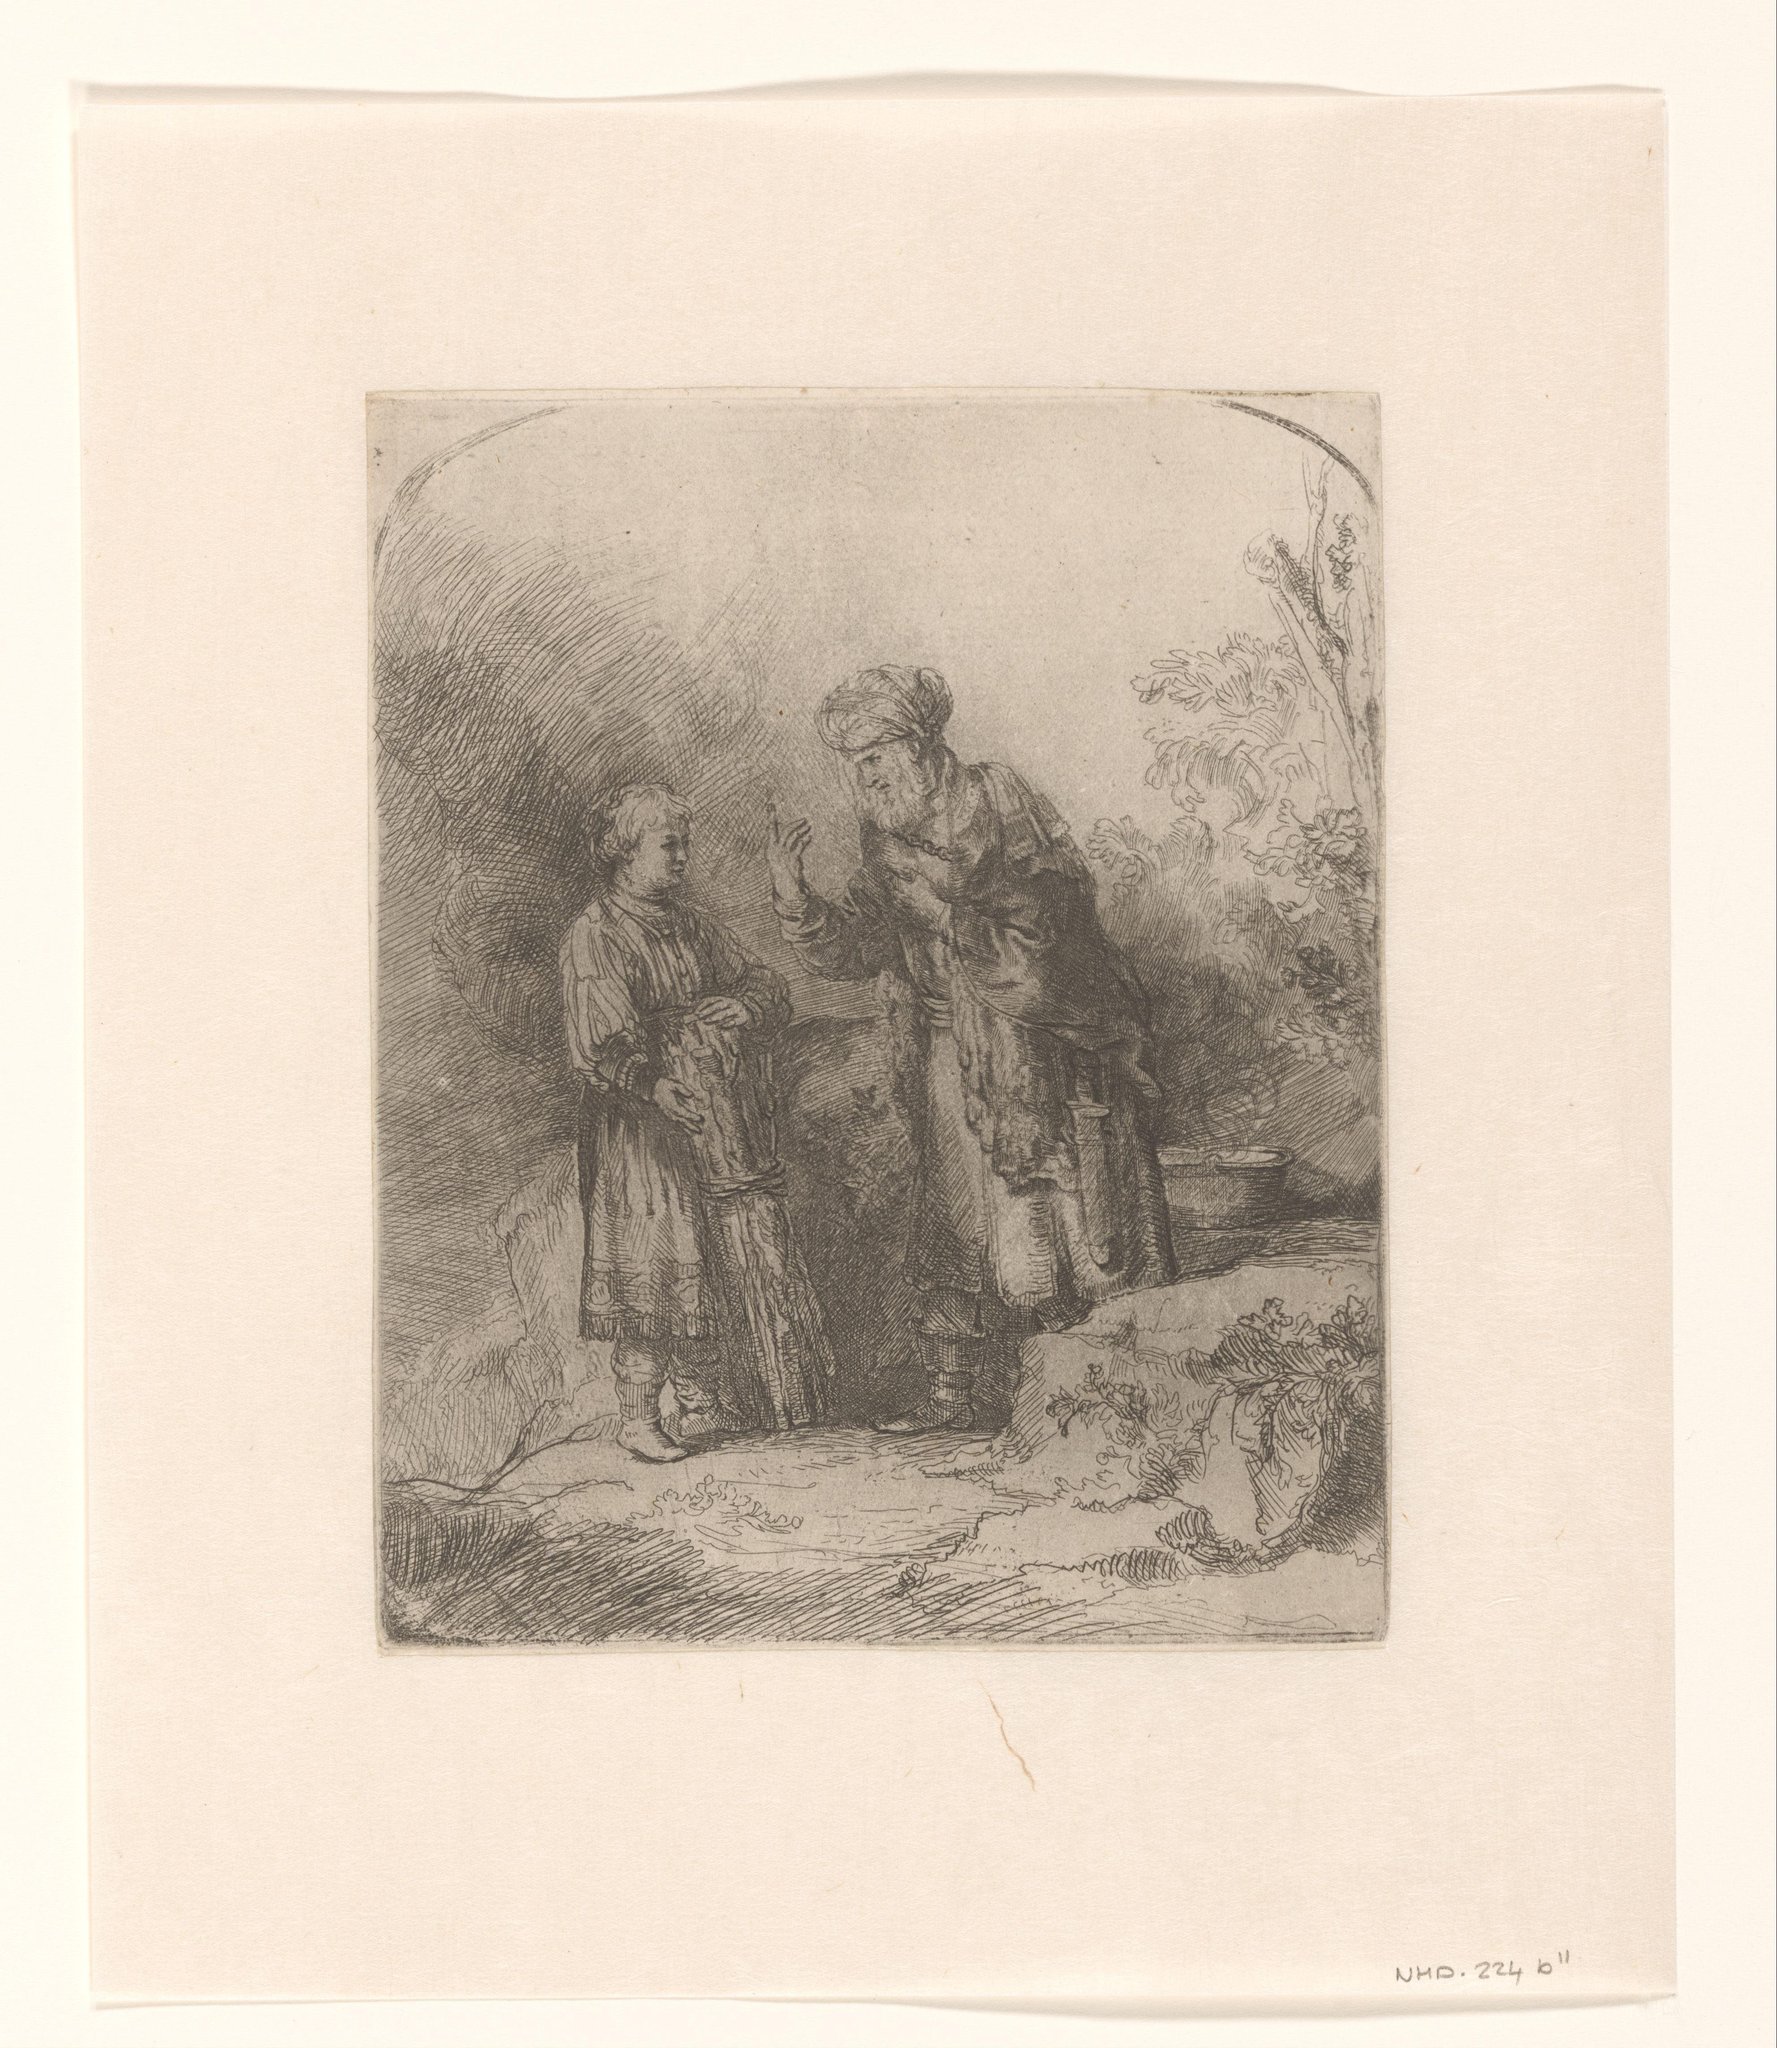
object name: print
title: Abraham and Isaac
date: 1819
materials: paper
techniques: etching, intaglio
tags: story of abraham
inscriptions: collector's mark: Lugt 2228, collector's mark: Lugt 2760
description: Spiegelbeeldige kopie naar de gelijknamige prent van Rembrandt. Prent voor het eerst gebruikt in: Recueil de Quatre-Vingt-Cinq estampes originales, têtes, paysages et différens sujets, dessinées et gravées par Rembrandt. Parijs: Henry Louis Basan, 1819.